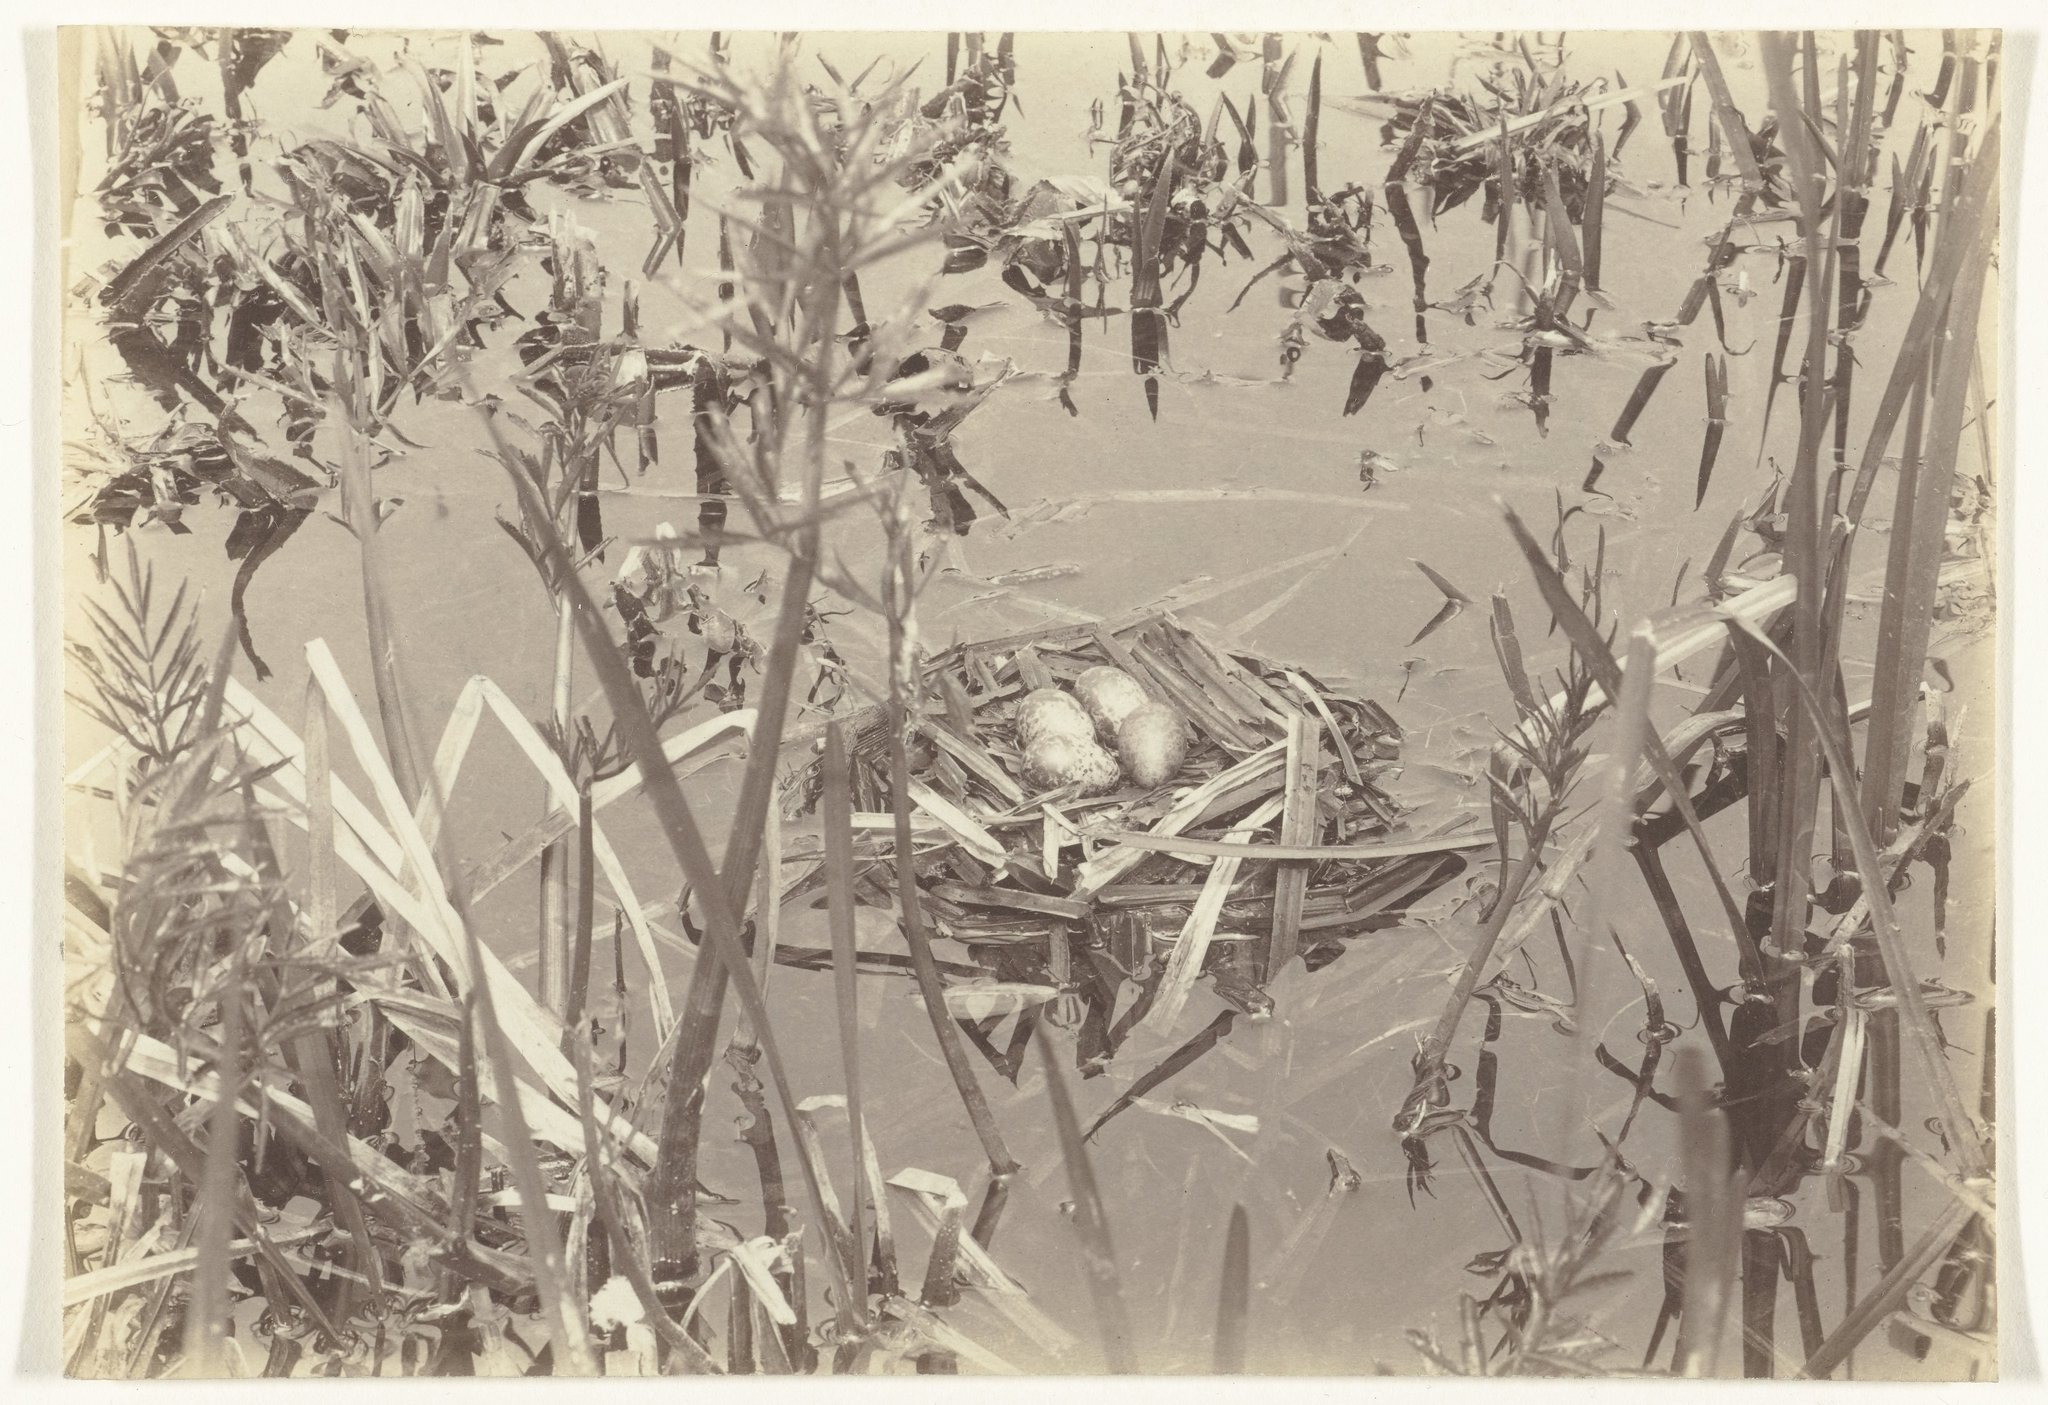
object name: photograph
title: Drijvend nest van een zwarte stern bij het Naardermeer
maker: richard tepe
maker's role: fotograaf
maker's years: 1864-1952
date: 1900-1930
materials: photographic support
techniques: albumen print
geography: netherlands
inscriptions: annotation: ‘Schwimmendes Nest / der Trauerseeschwalbe / oder schwarze Seeschwalbe / im Naardermeer Holland’, signature: ‘foto / R Tepe’